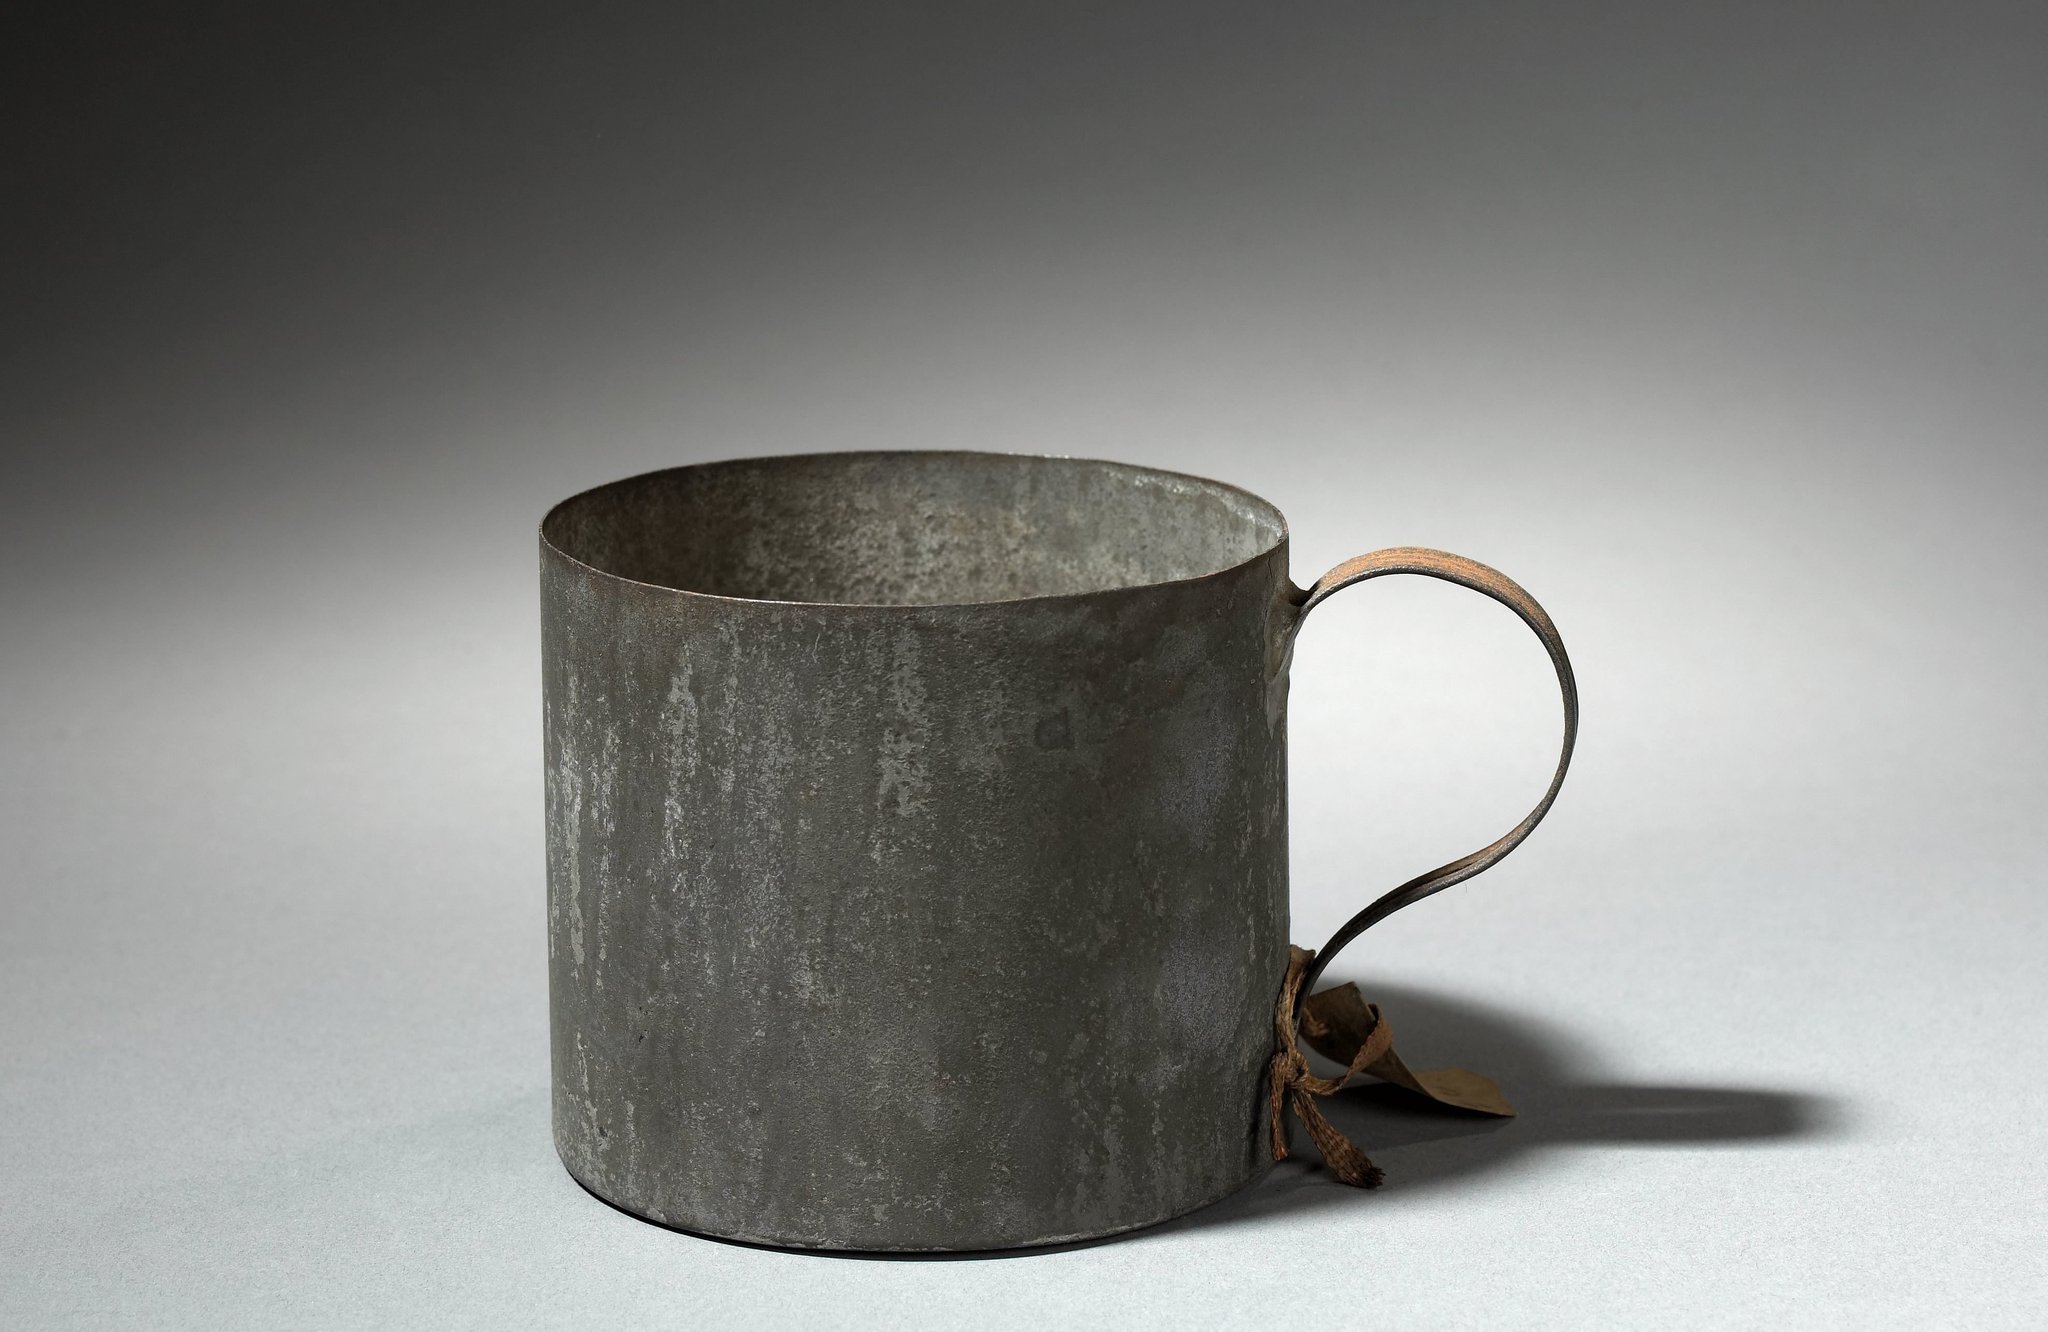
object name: oliemaat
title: Maat van 1 oliemaatje met handvat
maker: Anonymous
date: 1810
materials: metal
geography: netherlands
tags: netherlands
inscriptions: label: ‘45’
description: Maat van 1 oliemaatje met handvat (ca. 1/2 liter), v.z.v. label.